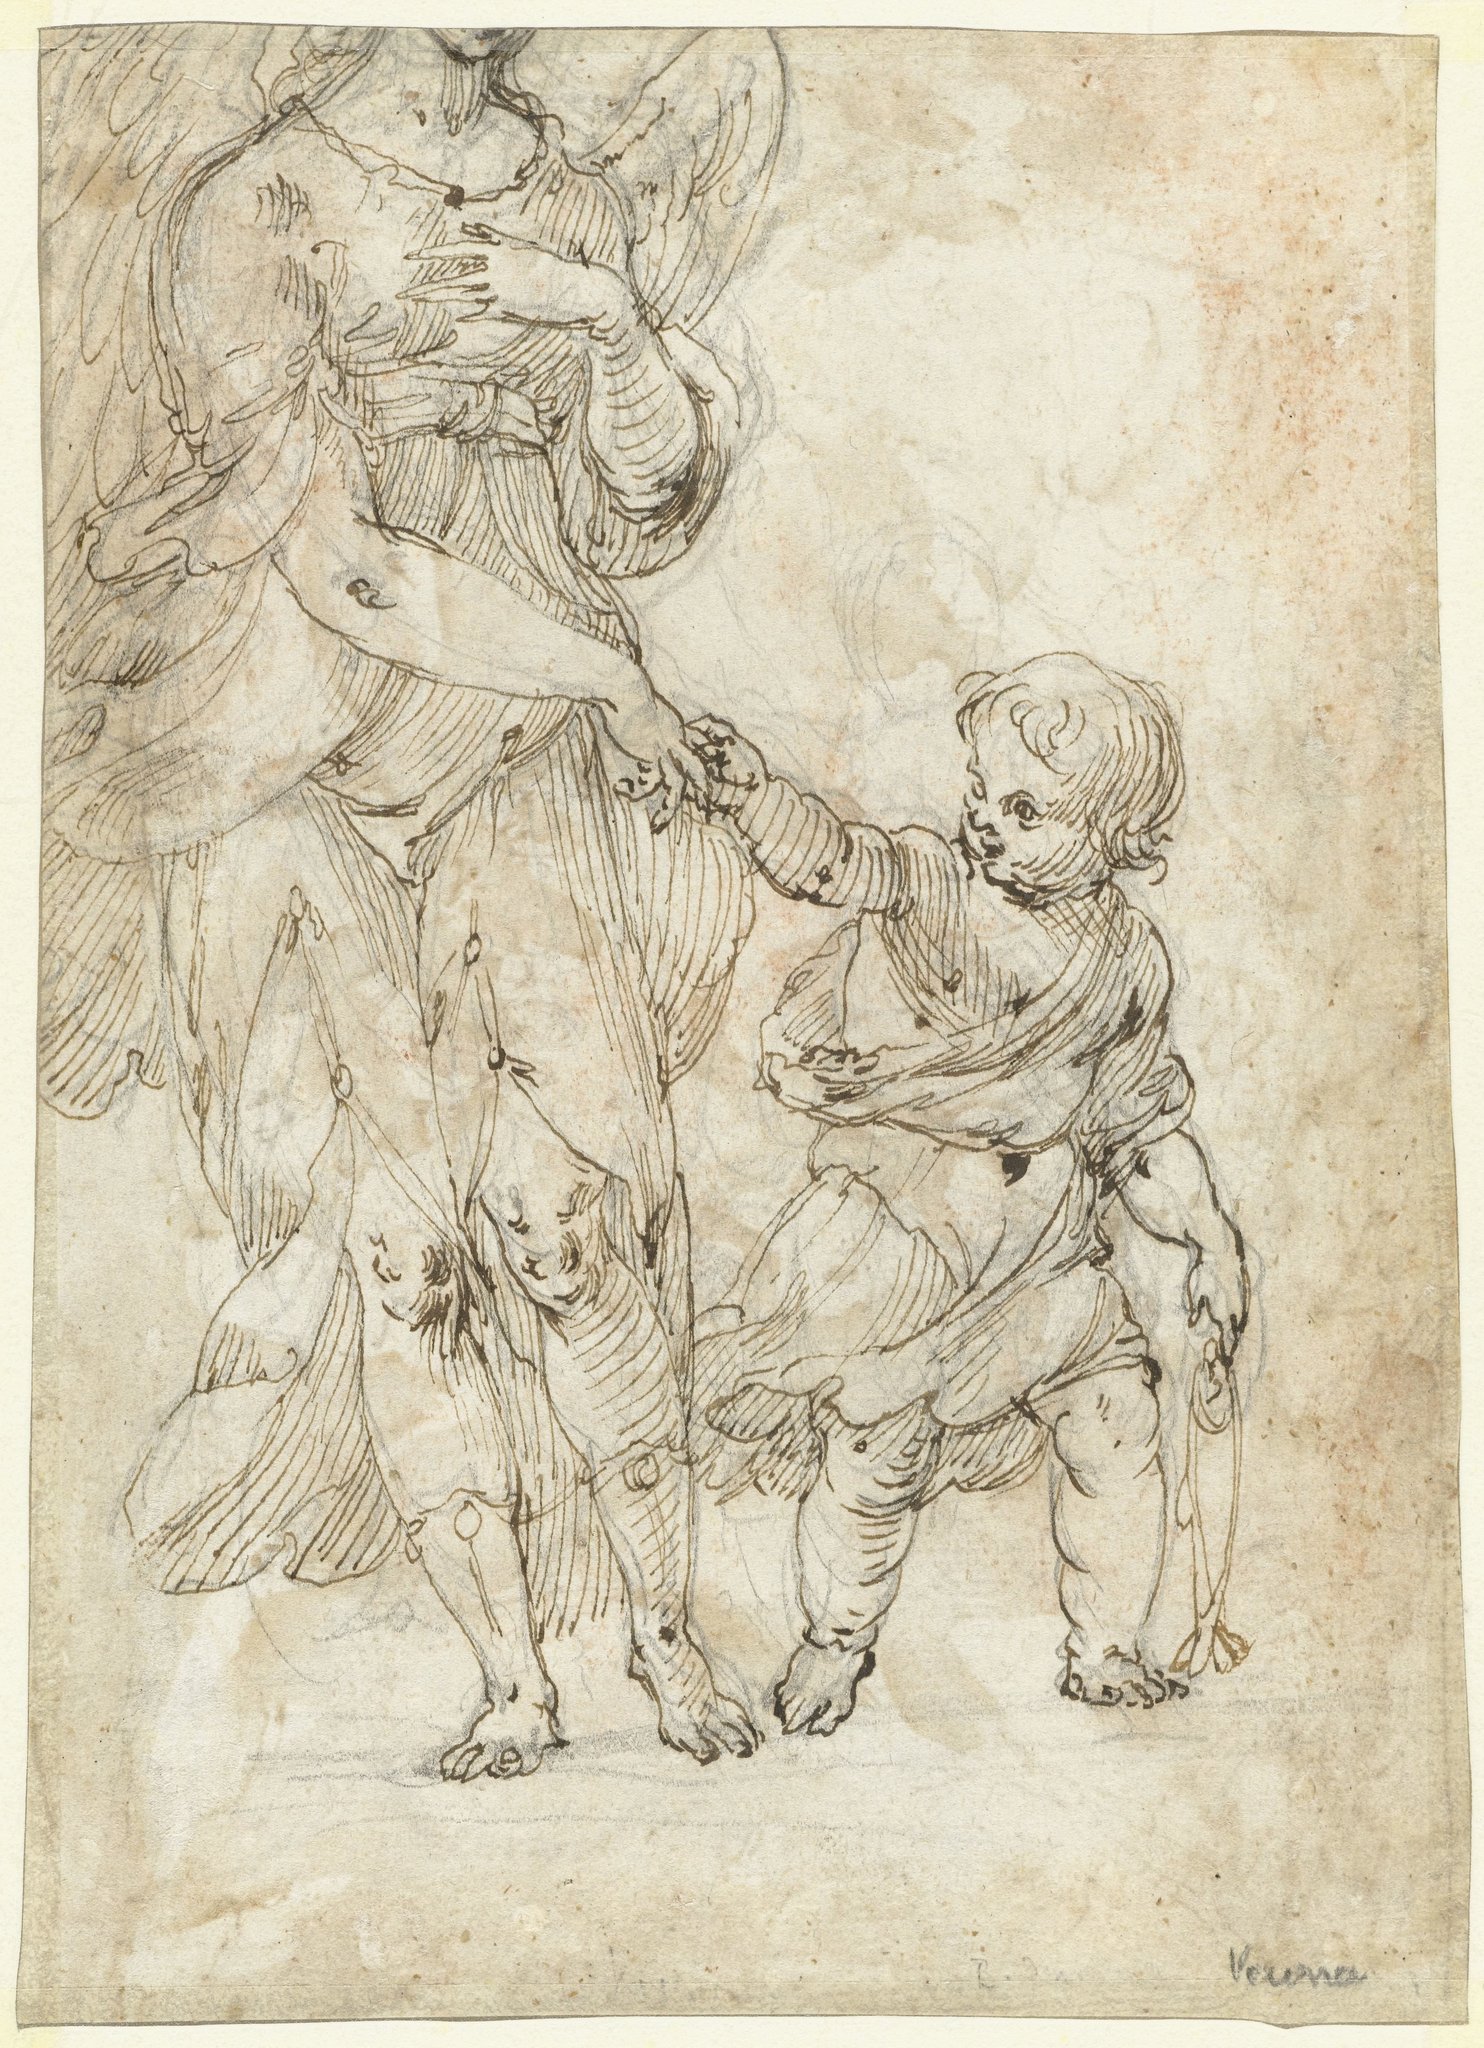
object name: drawing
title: Tobias en de engel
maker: antonio maria viani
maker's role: draughtsman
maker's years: 1555-1629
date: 1570-1629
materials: chalk, ink, paper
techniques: pen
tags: tobias and the angel raphael travelling, accompanied by tobias' dog